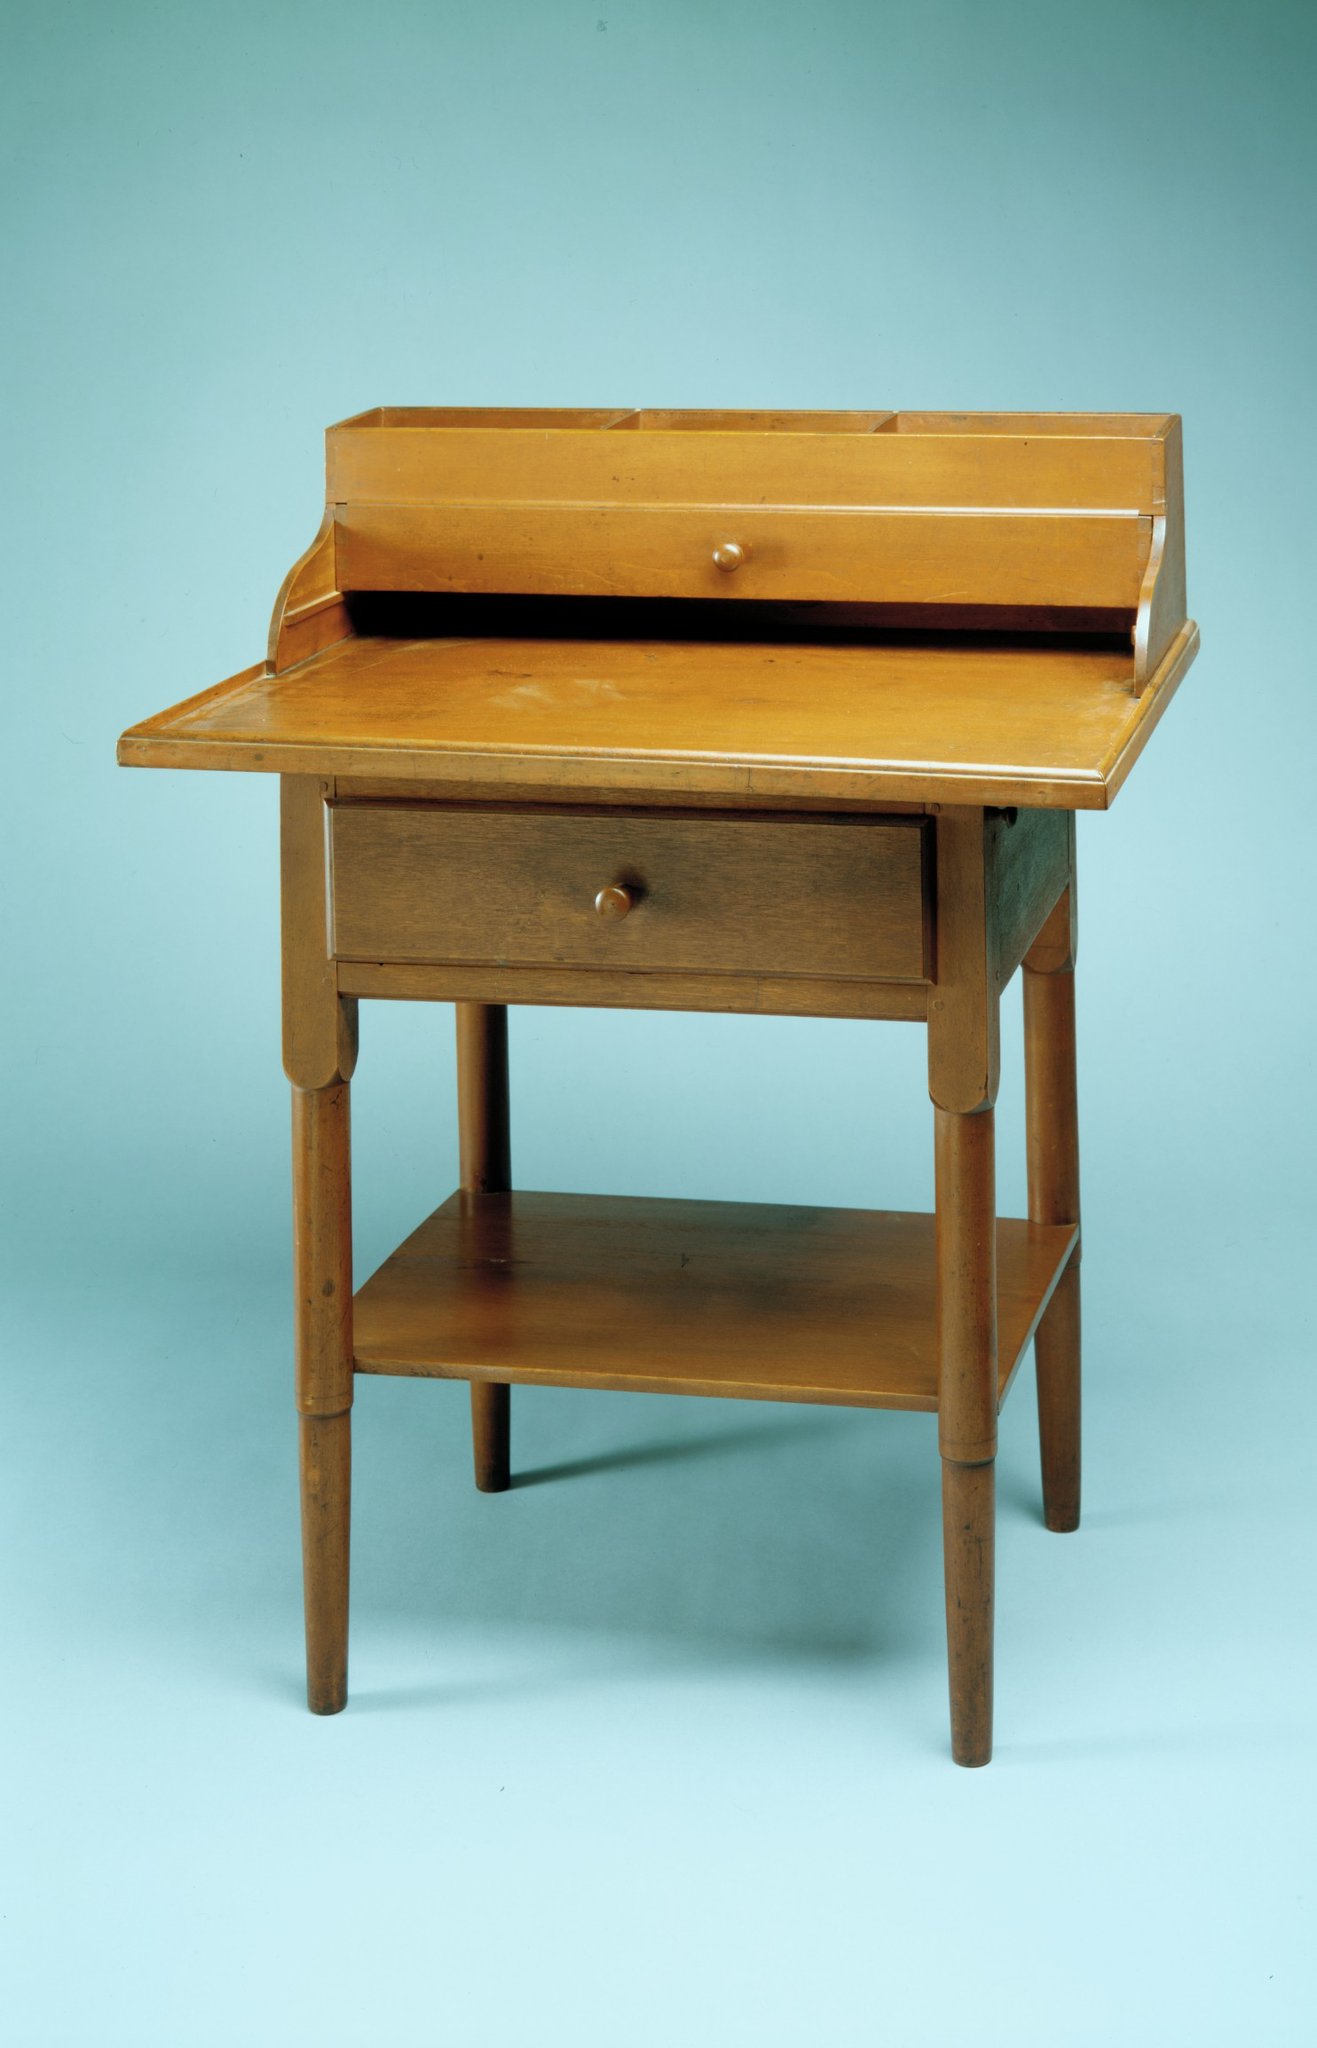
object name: stand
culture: american, shaker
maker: united society of believers in christ’s second appearing (“shakers”)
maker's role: maker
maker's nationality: american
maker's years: 1750-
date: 1825-1850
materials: wood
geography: united states